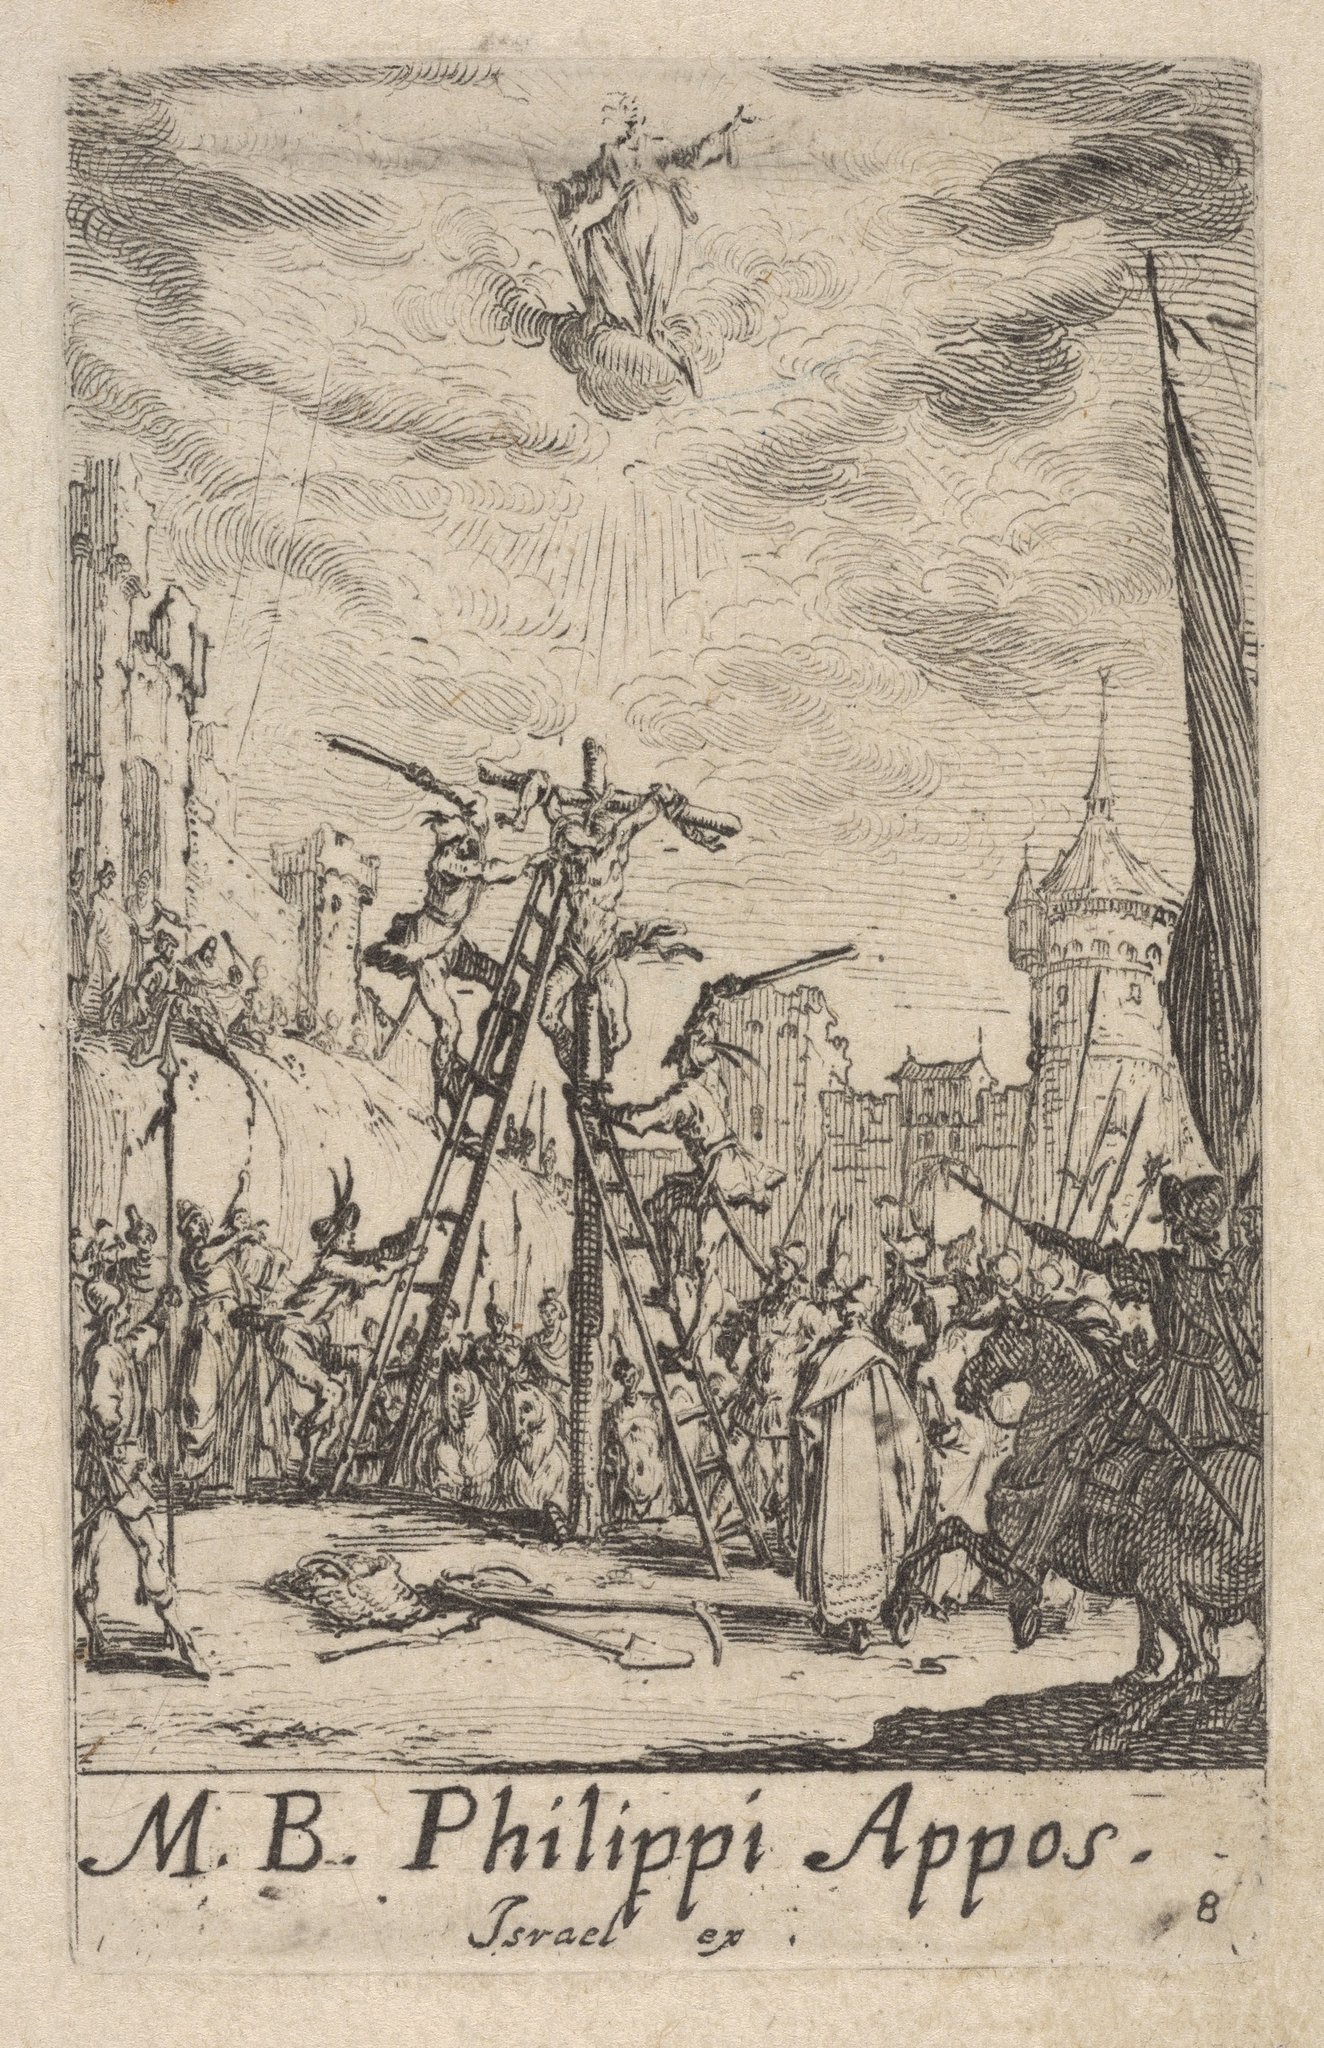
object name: print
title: Martyrdom of Saint Philip, from "The Little Apostles" (Les Petits Apôtres)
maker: jacques callot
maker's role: artist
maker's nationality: french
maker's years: 1592-1635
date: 1632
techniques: etching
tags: apostles,crucifixion